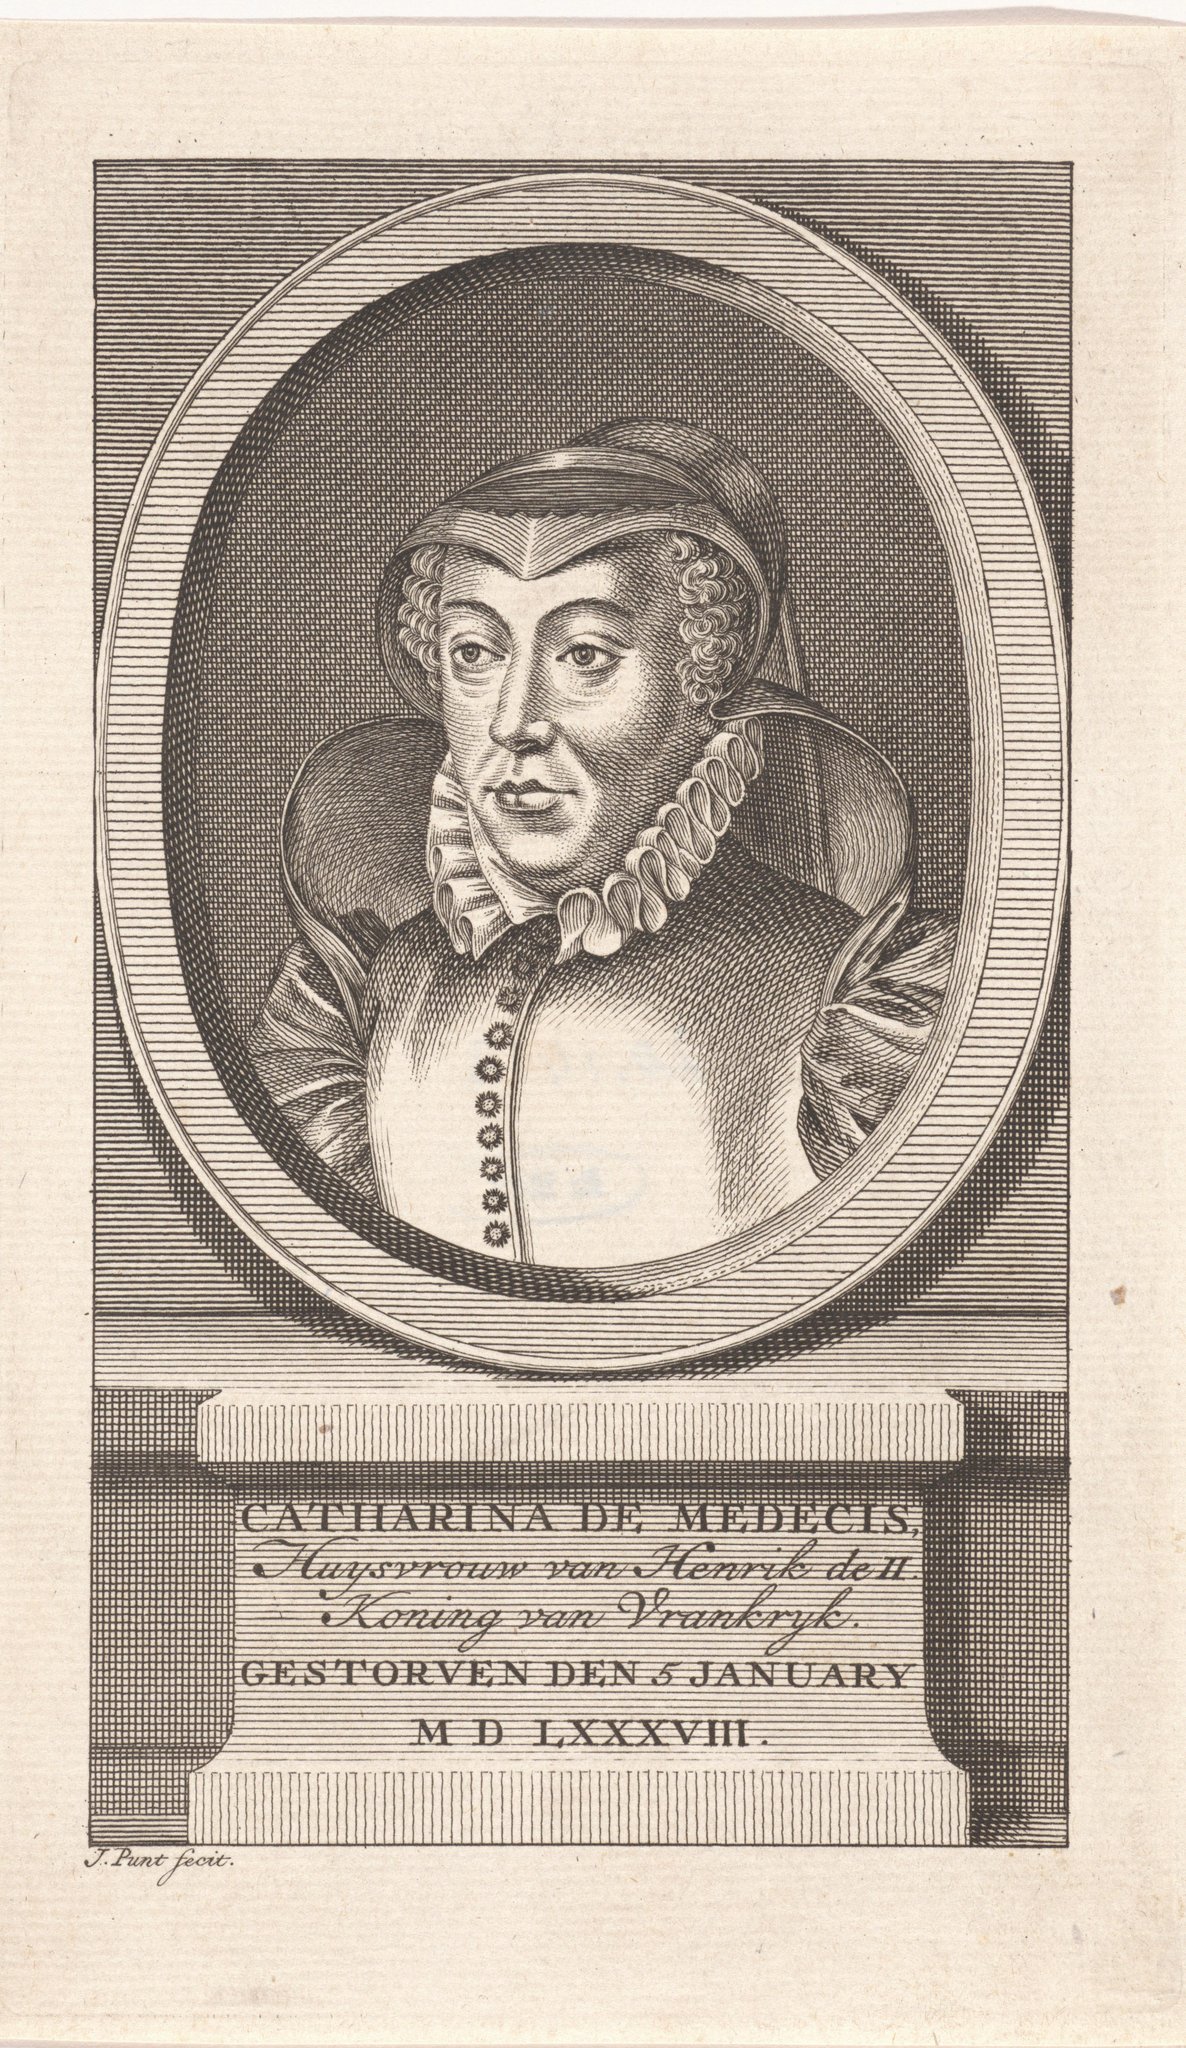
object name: print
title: Portret van Catharina de' Medici, koningin van Frankrijk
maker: jan punt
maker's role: draughtsman, print maker, publisher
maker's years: 1711-1779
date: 1786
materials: paper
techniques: engraving, etching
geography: northern netherlands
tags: florence, blois, koningin, catharina de'medici (koningin van frankrijk)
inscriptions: collector's mark: Lugt 2228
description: Prent gebruikt als illustratie in: Meteren, Emanuel van. Oorlogen en geschiedenissen der Nederlanderen en derzelver nabuuren, deel V, p. 263. Amsterdam: Steven Jacobus Baalde, 1786.